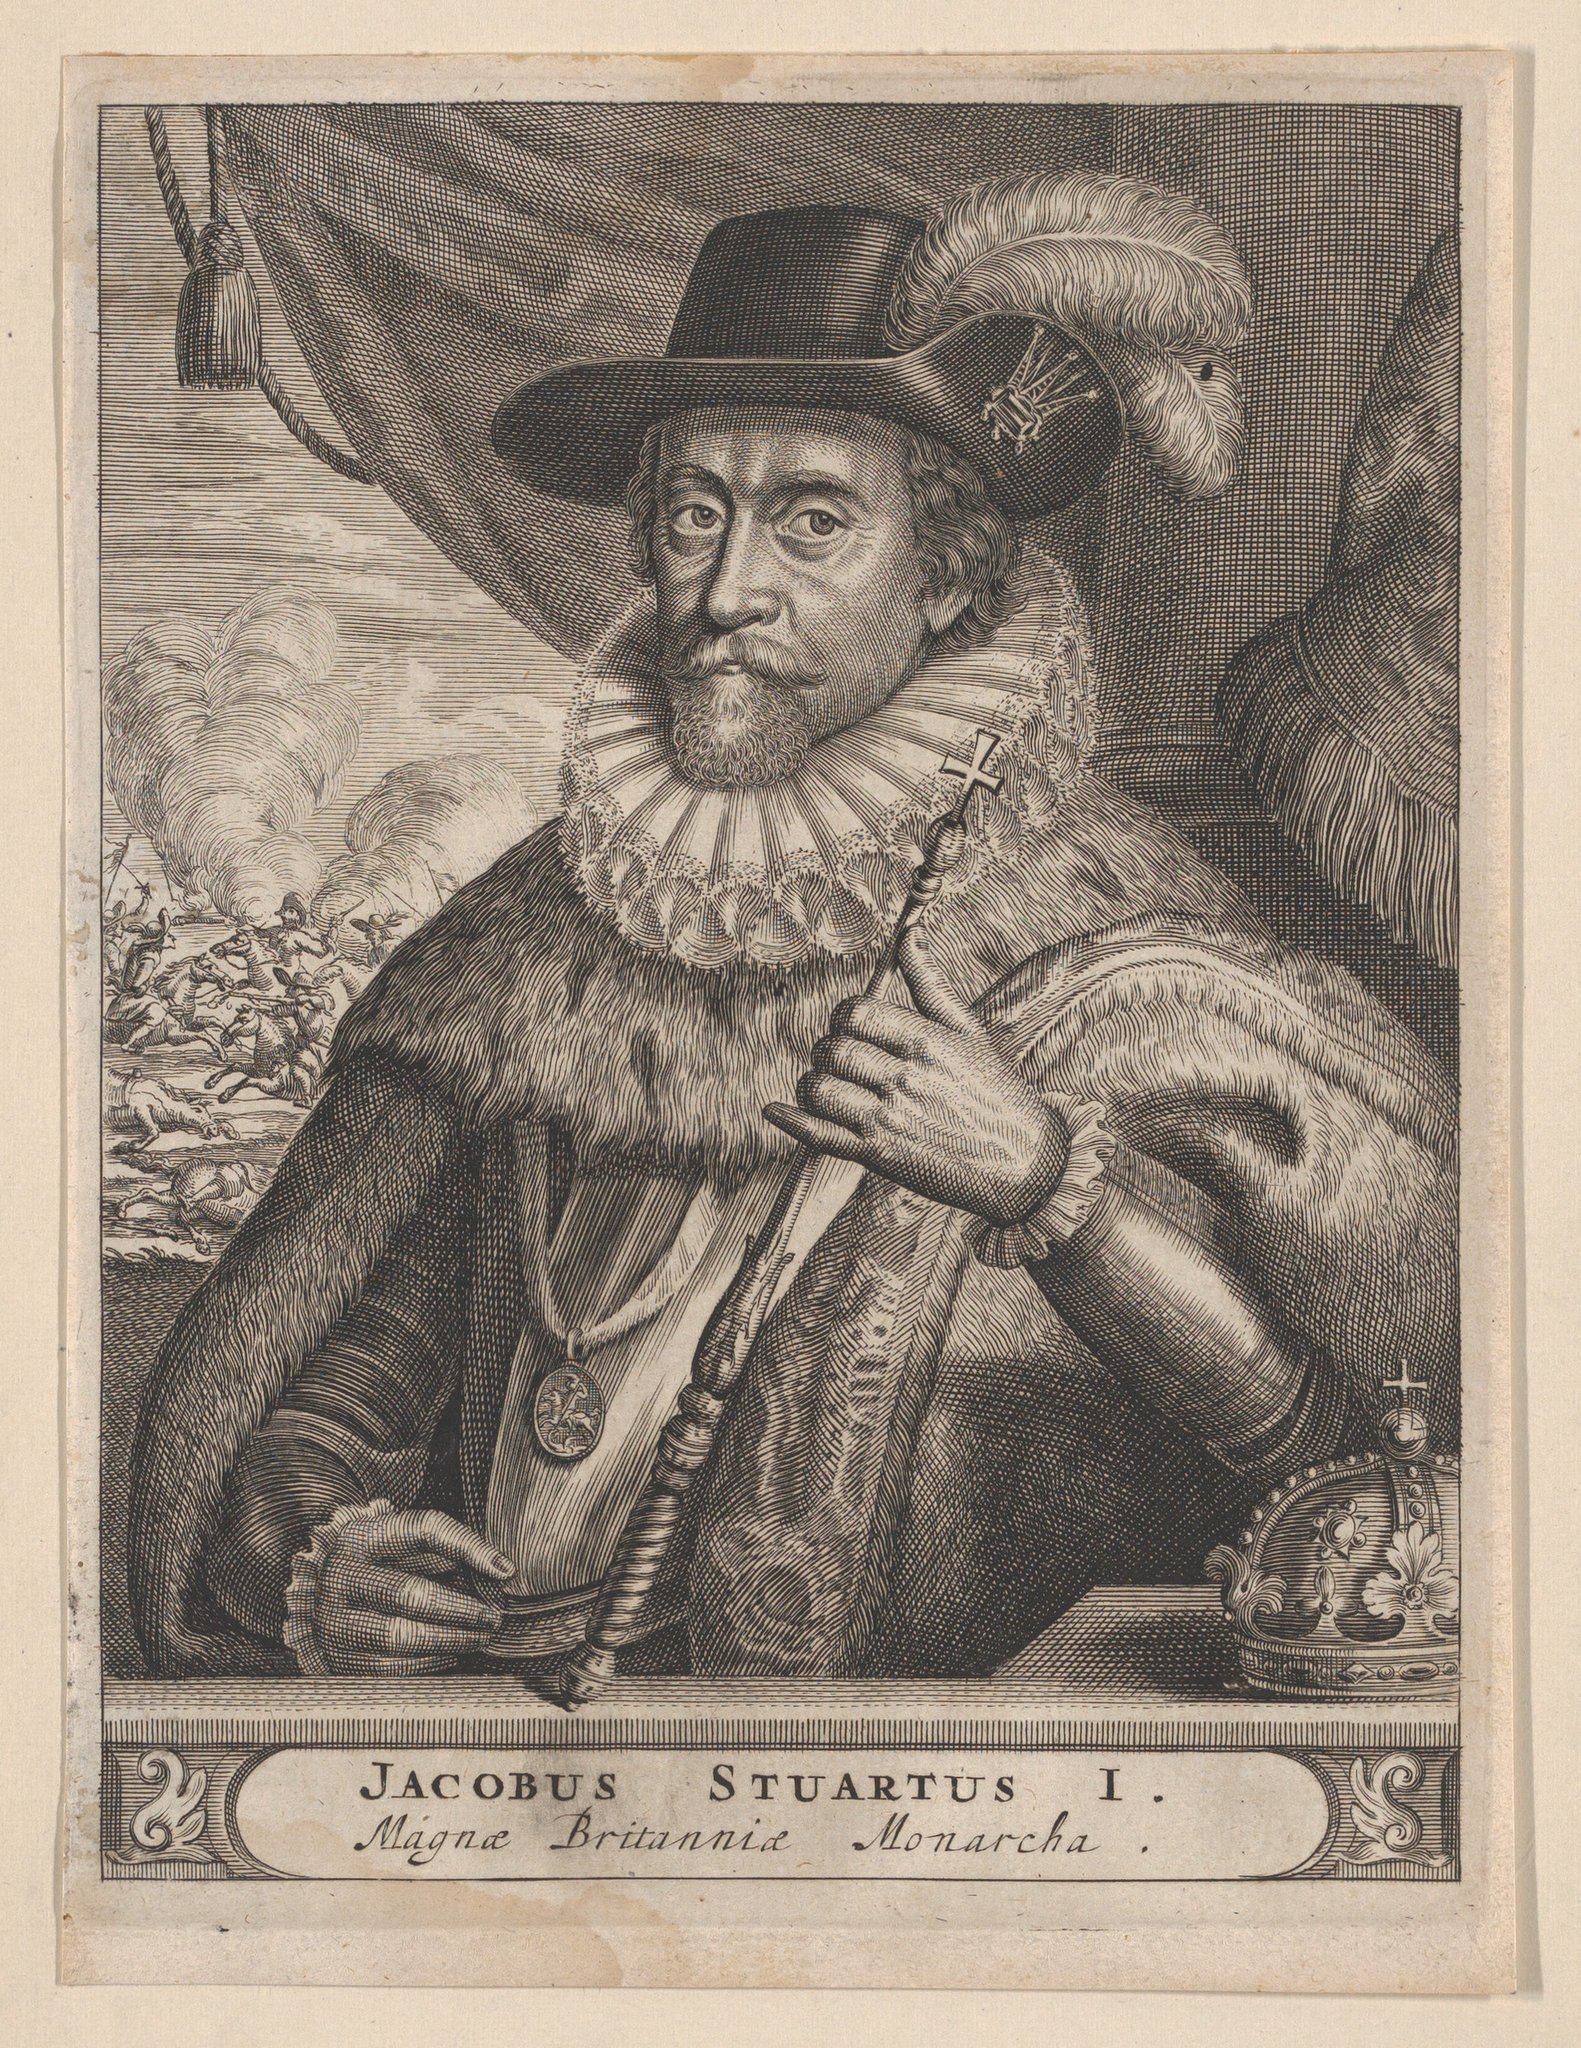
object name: print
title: Jacobus Stuartus I. Magnæ Britanniæ Monarcha (James I, King of England)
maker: anonymous, dutch, 17th century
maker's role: engraver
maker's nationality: dutch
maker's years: 1600-1700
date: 1601-1700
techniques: engraving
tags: kings,portraits